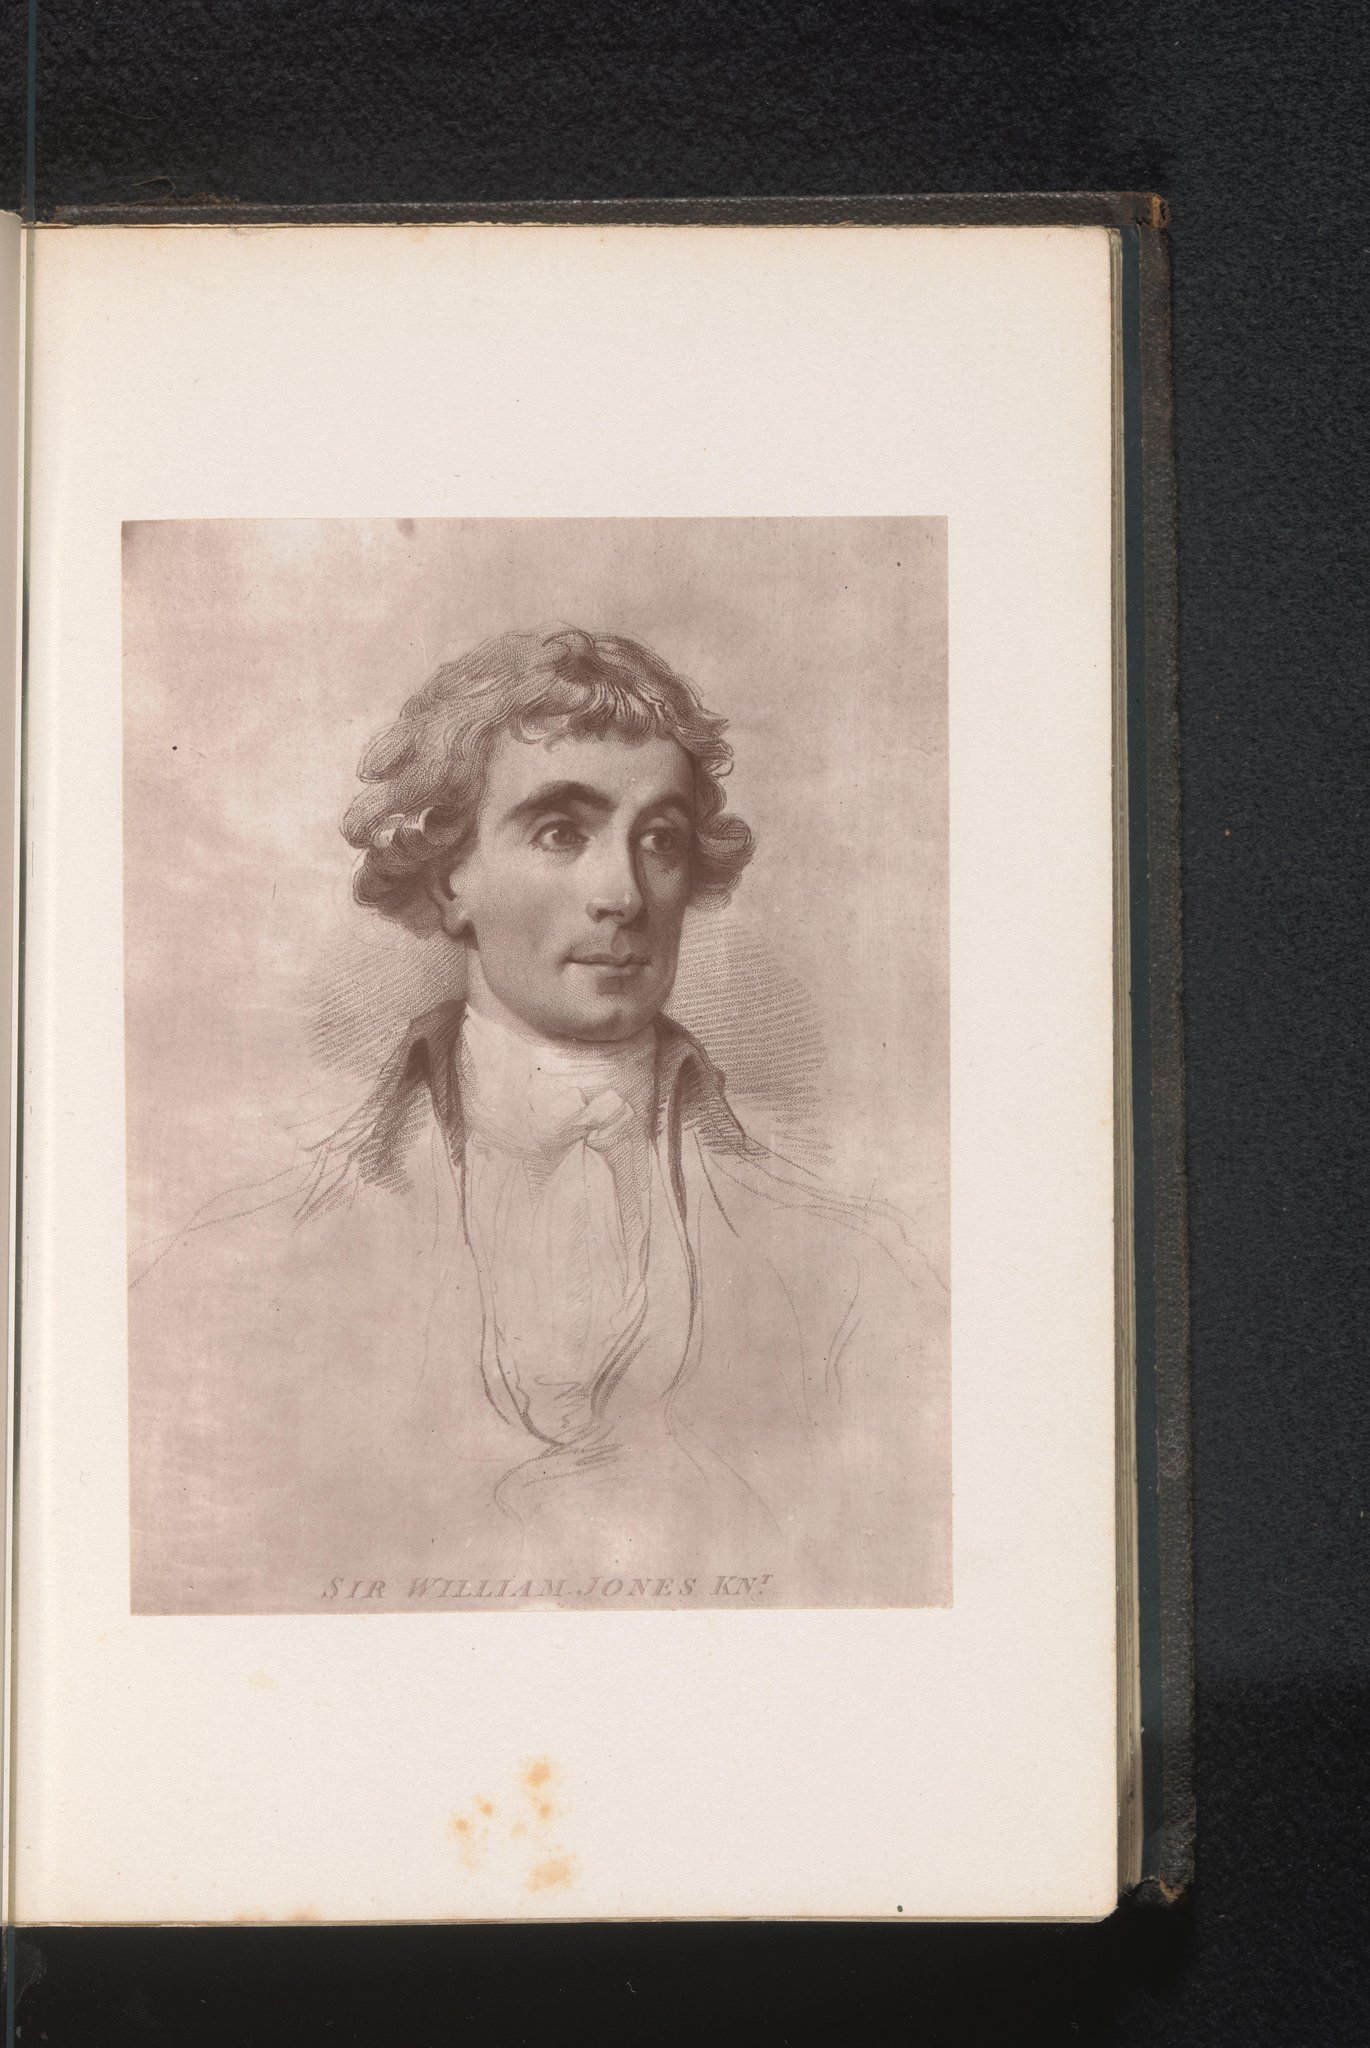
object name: photomechanical print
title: Fotoreproductie van een tekening, voorstellende een portret van William Jones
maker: Anonymous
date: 1866-1876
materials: paper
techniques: woodburytype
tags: scholar, philosopher, historical persons (portraits and scenes from the life) (+ head (and shoulders) (portrait))